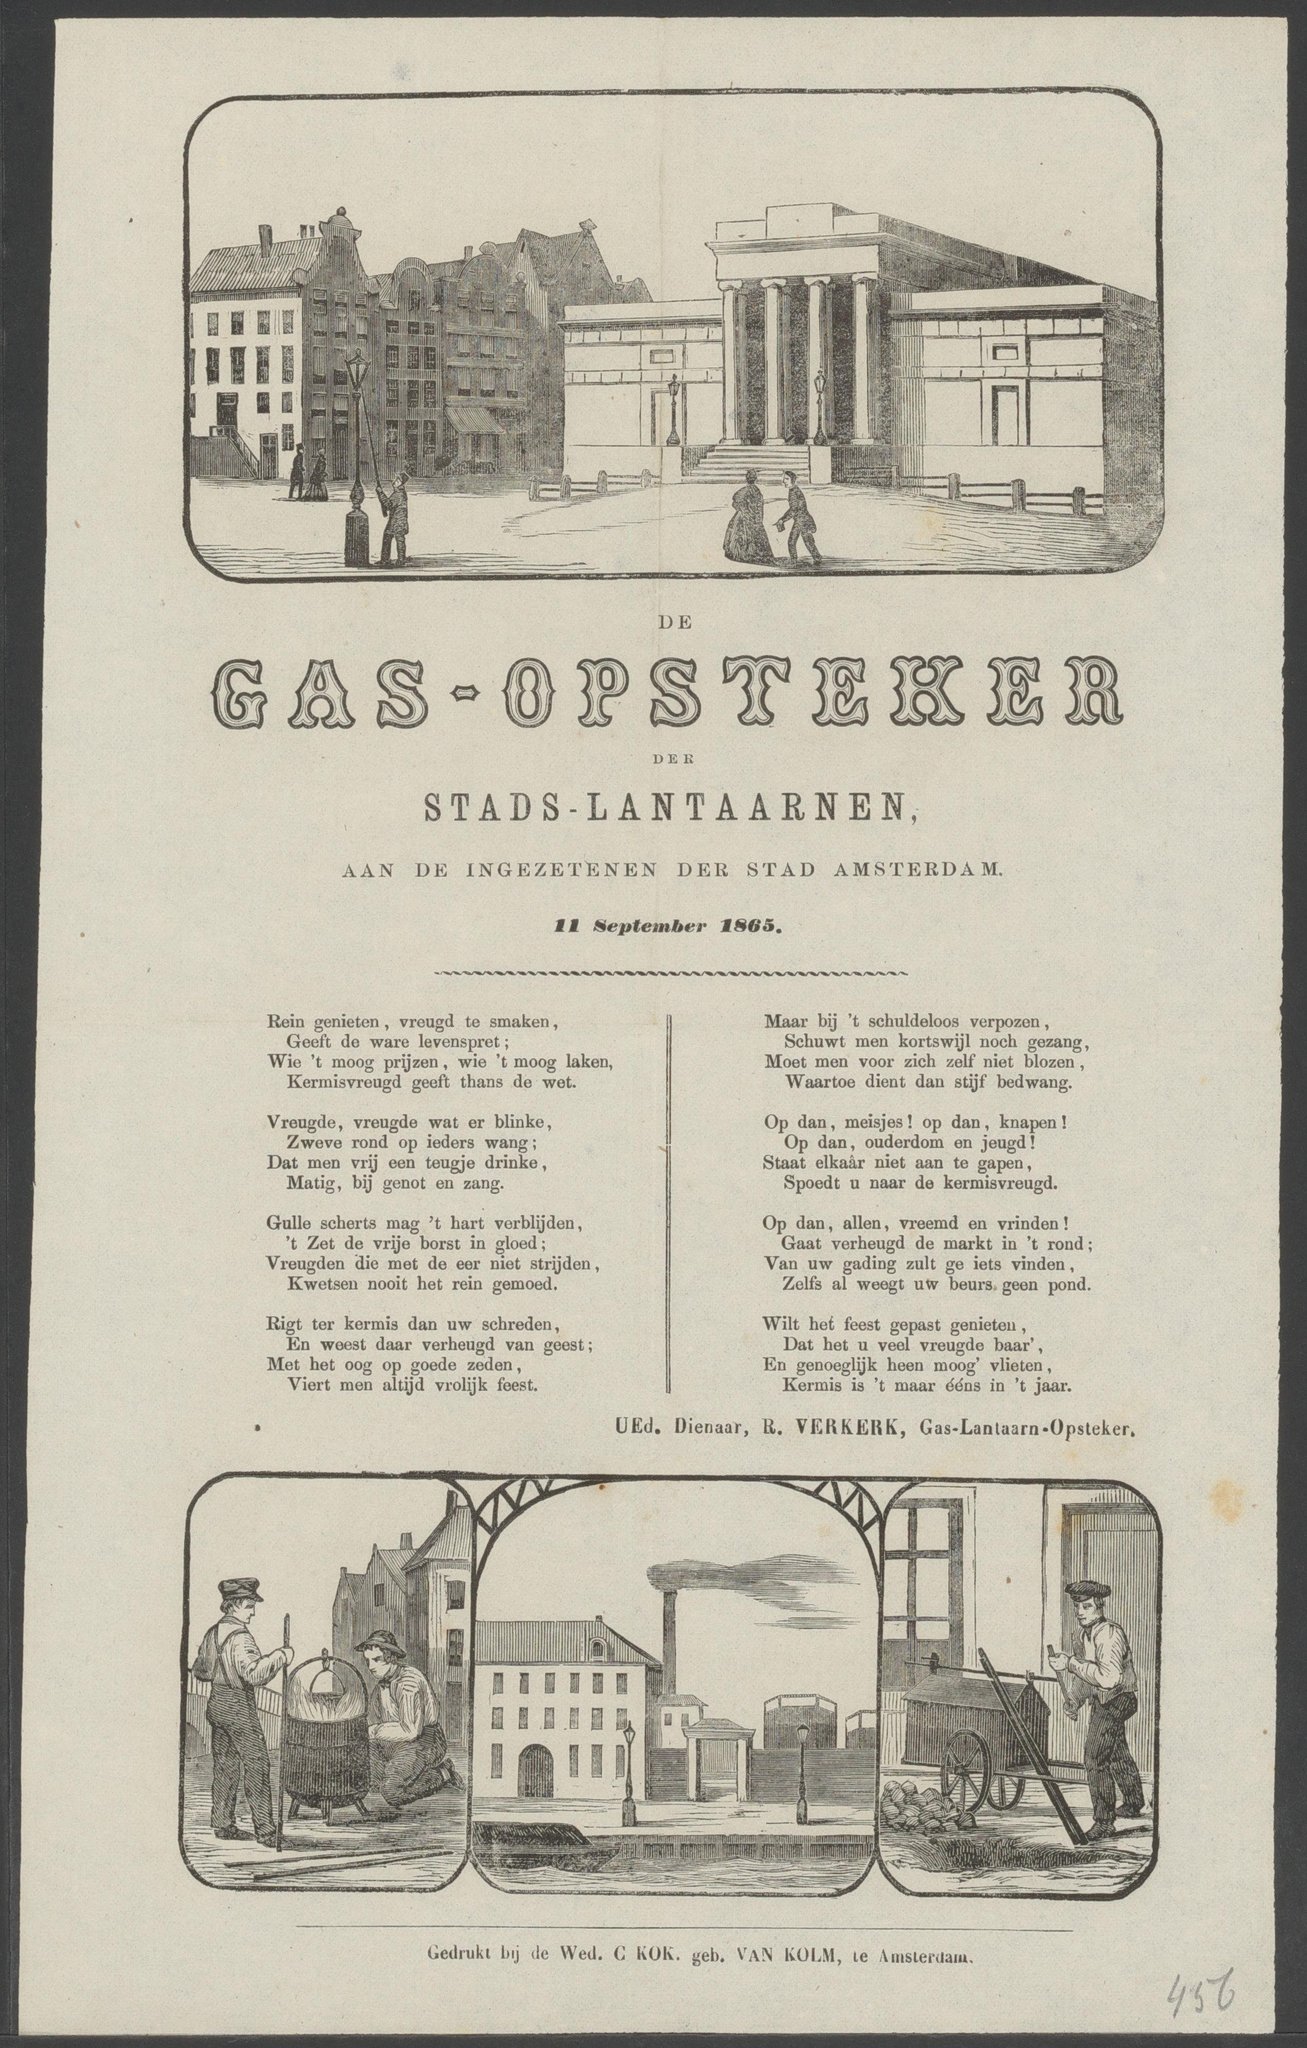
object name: print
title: De Gas-opsteker der Stads-lantaarnen, aan de ingezetenen der stad Amsterdam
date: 1865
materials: paper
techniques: letterpress printing, engraving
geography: amsterdam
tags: gas-lamp, gas supply, digging (industrial process), street lighting, amsterdam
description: Kermiswens van de Amsterdamse gaslantaarnopstekers voor het jaar 1865. Centraal een vers in twee kolommen. Bovenaan de Dam met de beurs van Zocher te Amsterdam. Onderaan de Hollandsche Gasfabriek en twee gasfitters aan het werk. Van de gaslantaarnopsteker: R. Verkerk. Onderwerpsrubrieken binnen de Atlas Zeden en Gewoonten: Zeden en gewoonten in engeren zin, Volksleven, Volksbladen, Nieuwjaars- en Kerstwenschen, Amsterdam.